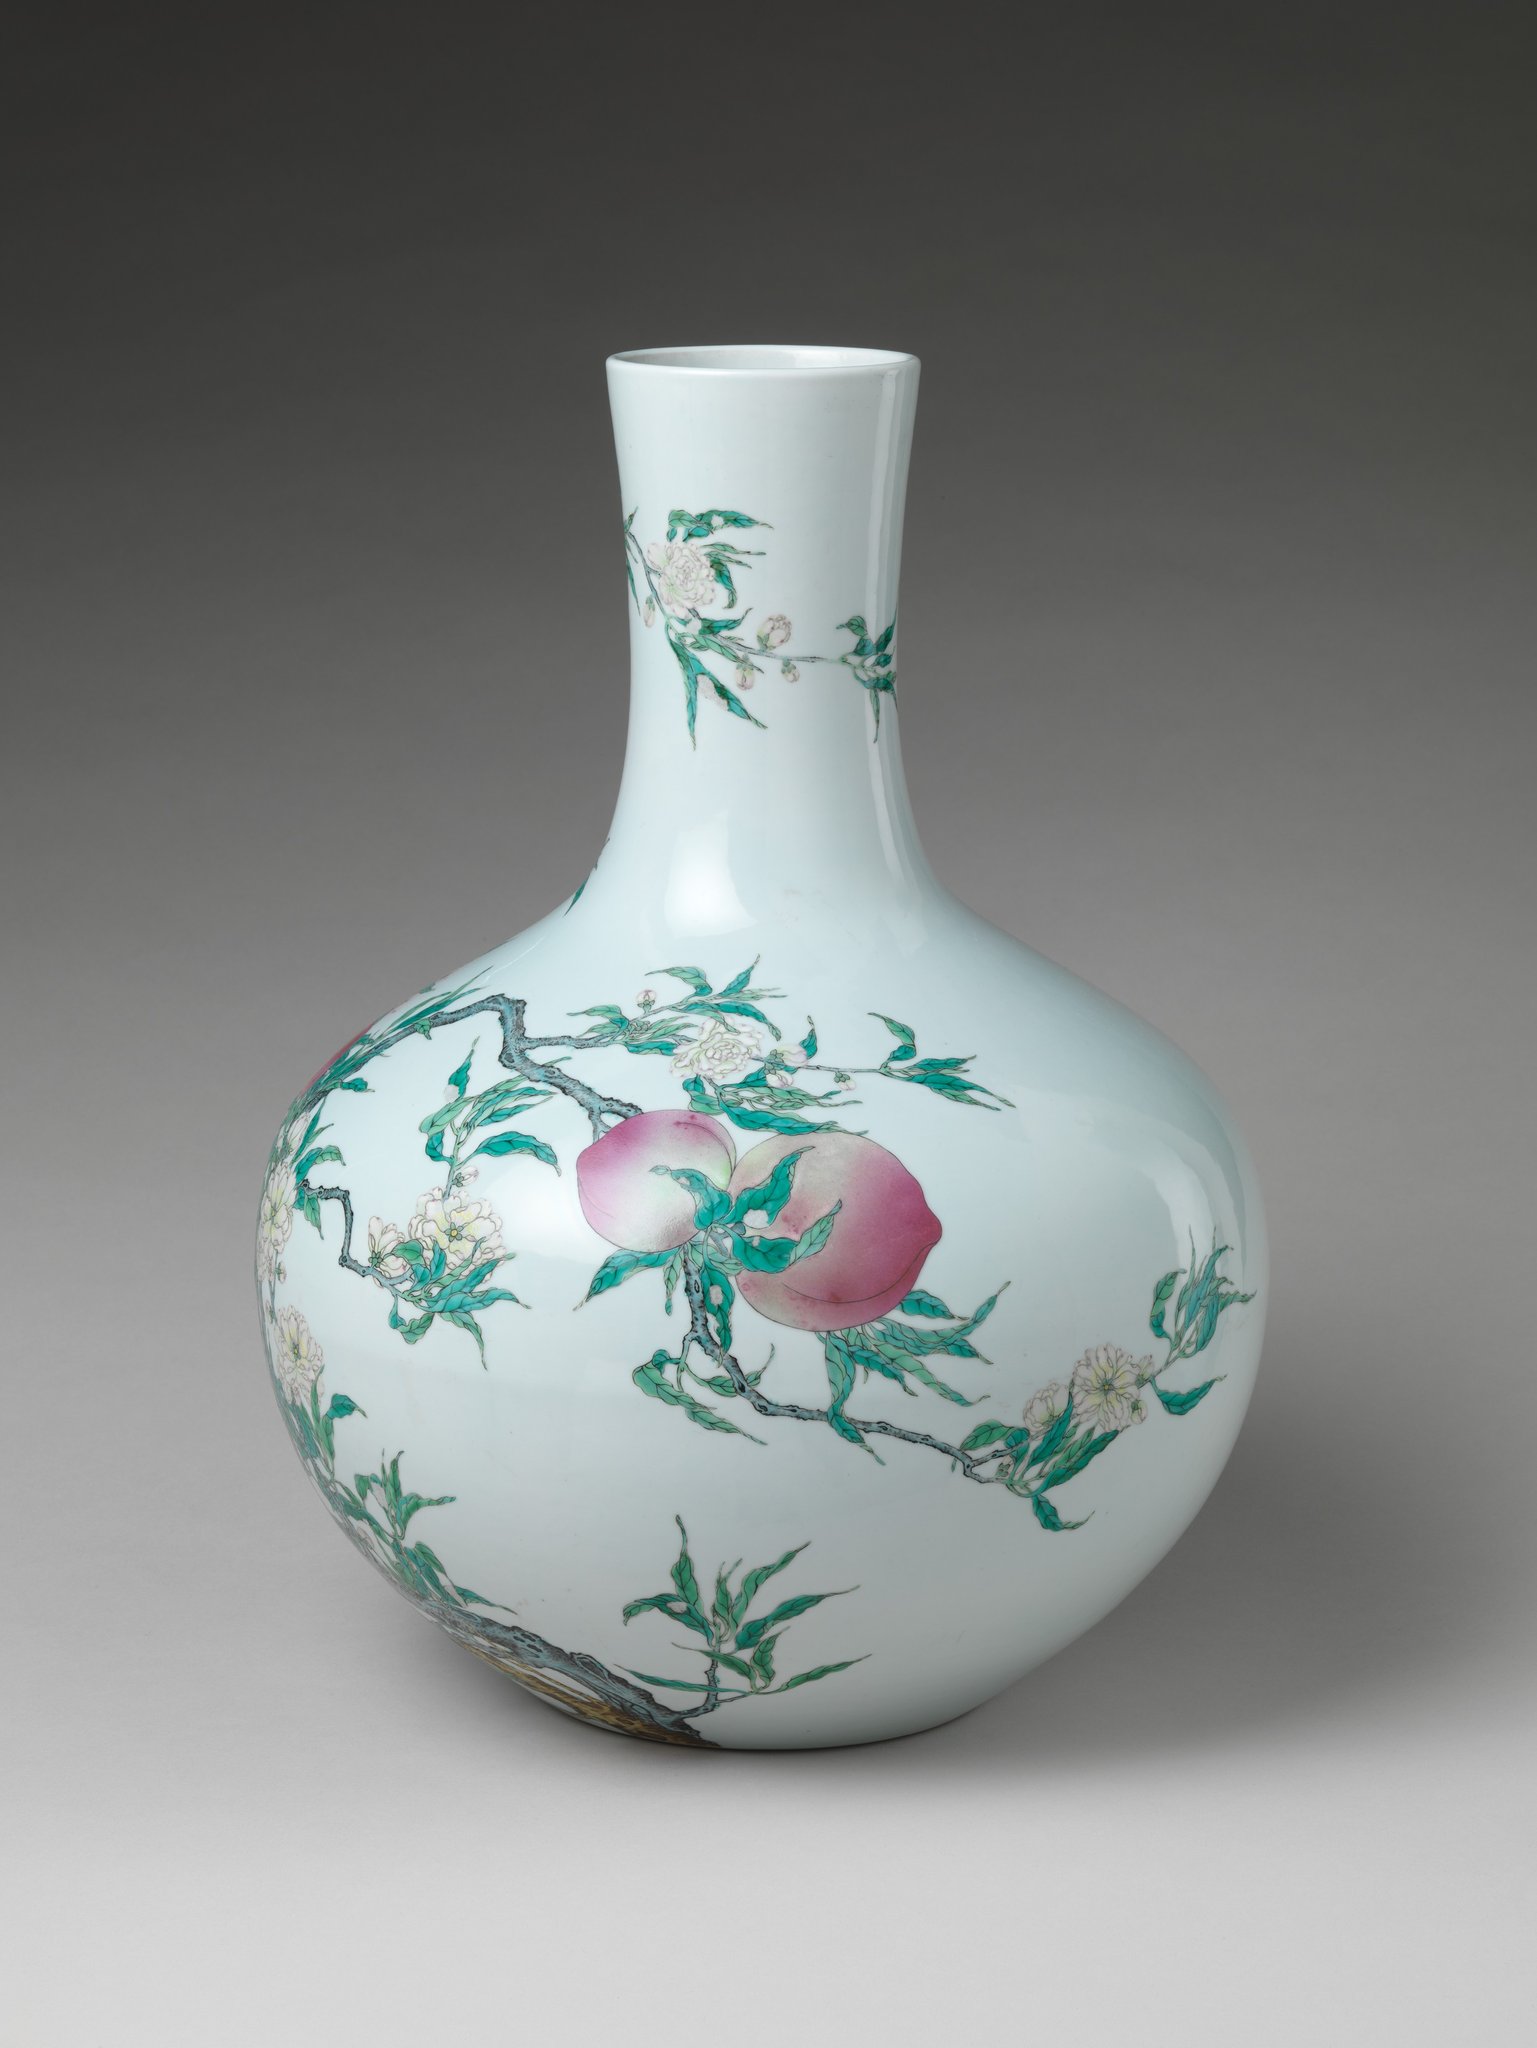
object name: vase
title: Vase with Nine Peaches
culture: chinese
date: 1736-1795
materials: enamel, glaze, porcelain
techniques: painting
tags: peaches